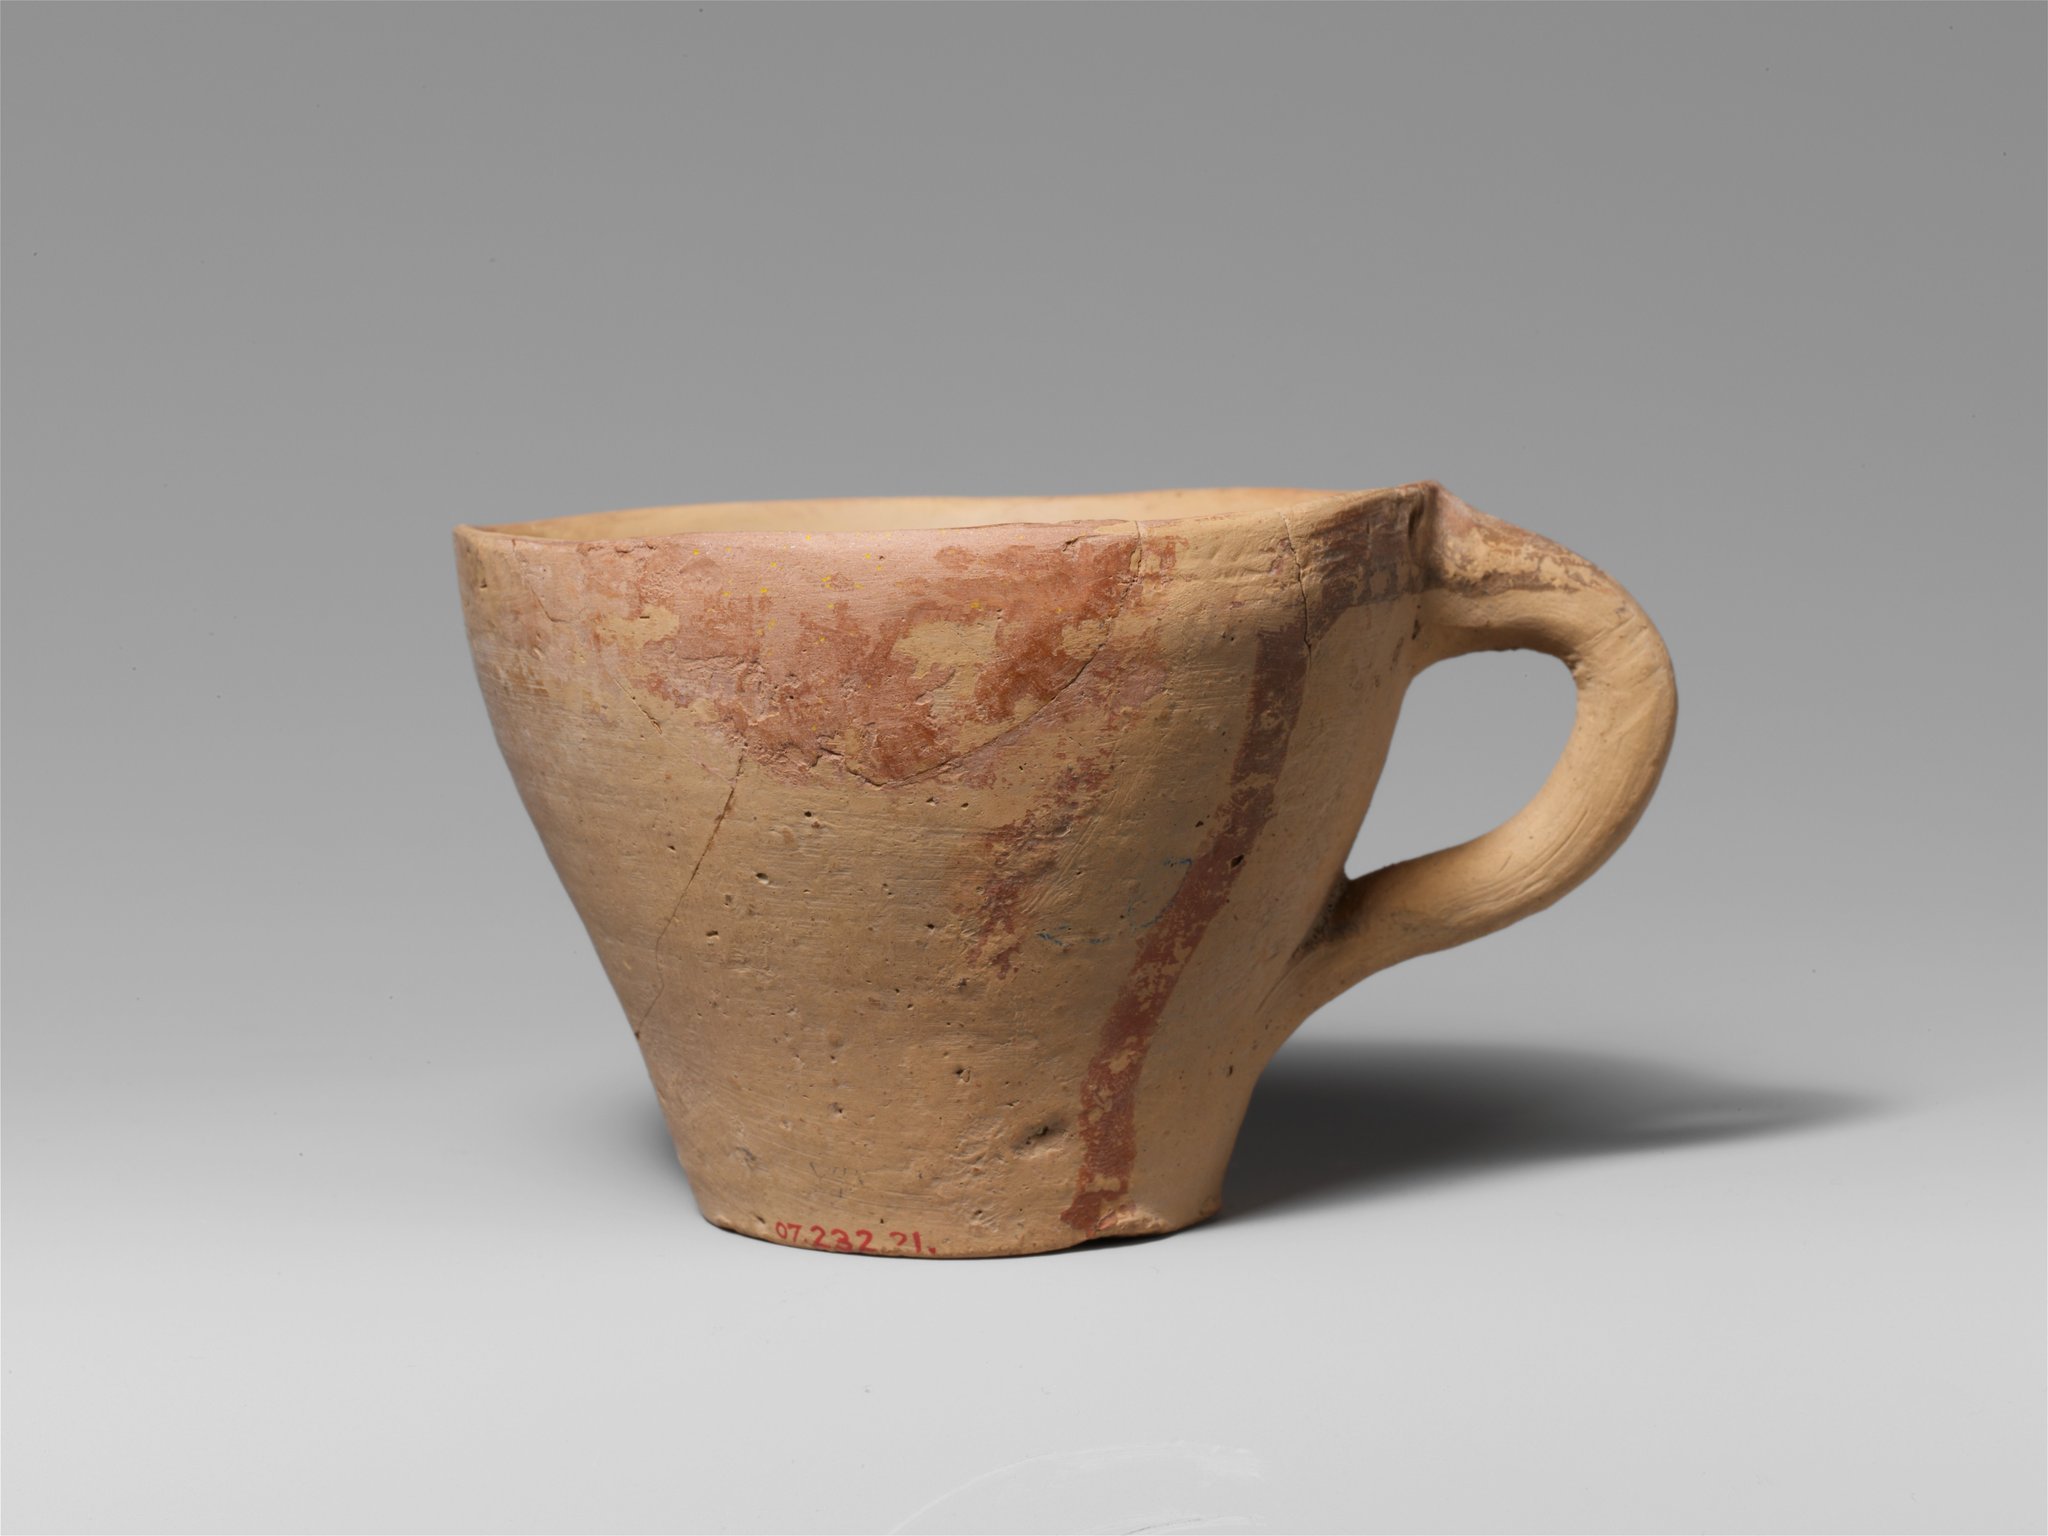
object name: cup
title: Terracotta one-handled cup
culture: minoan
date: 1400-1200 BCE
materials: terracotta